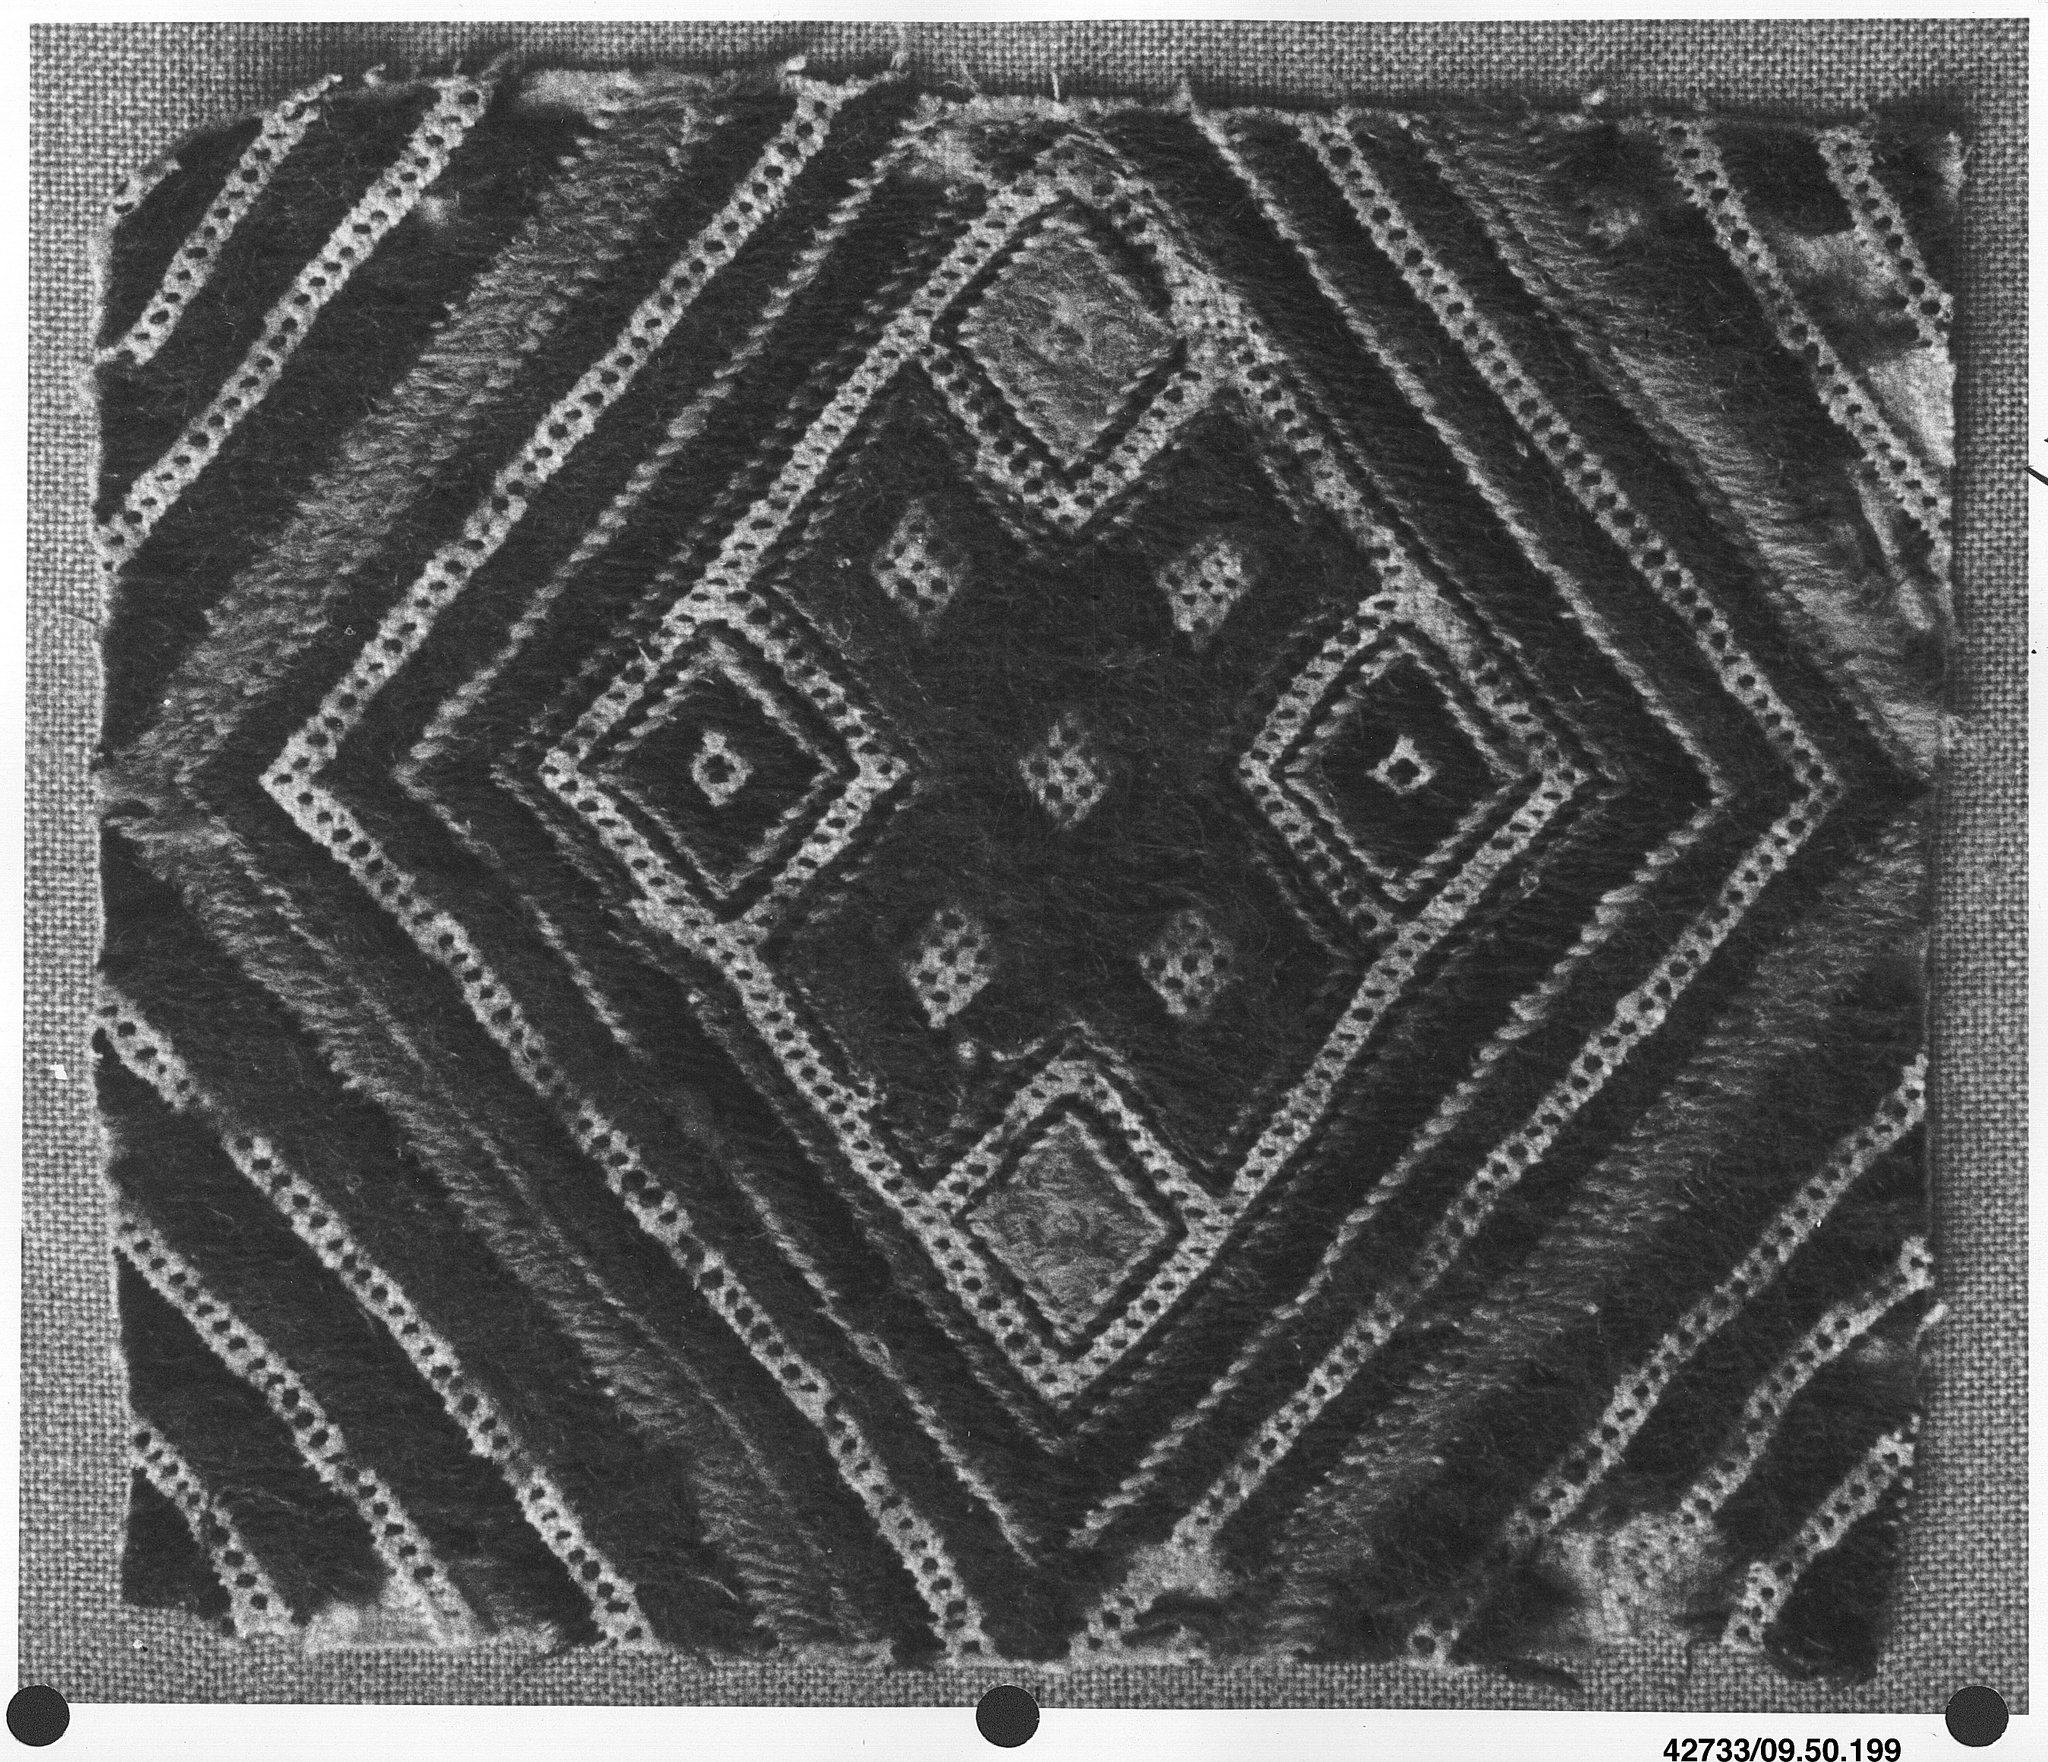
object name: costume fragment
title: Peasant costume fragment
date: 1701-1900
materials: canvas, wool